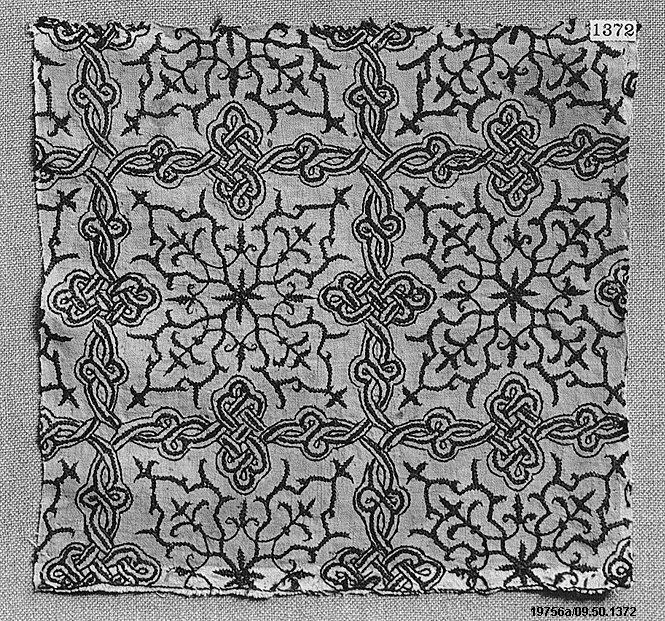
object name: fragment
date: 1601-1700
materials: linen, silk